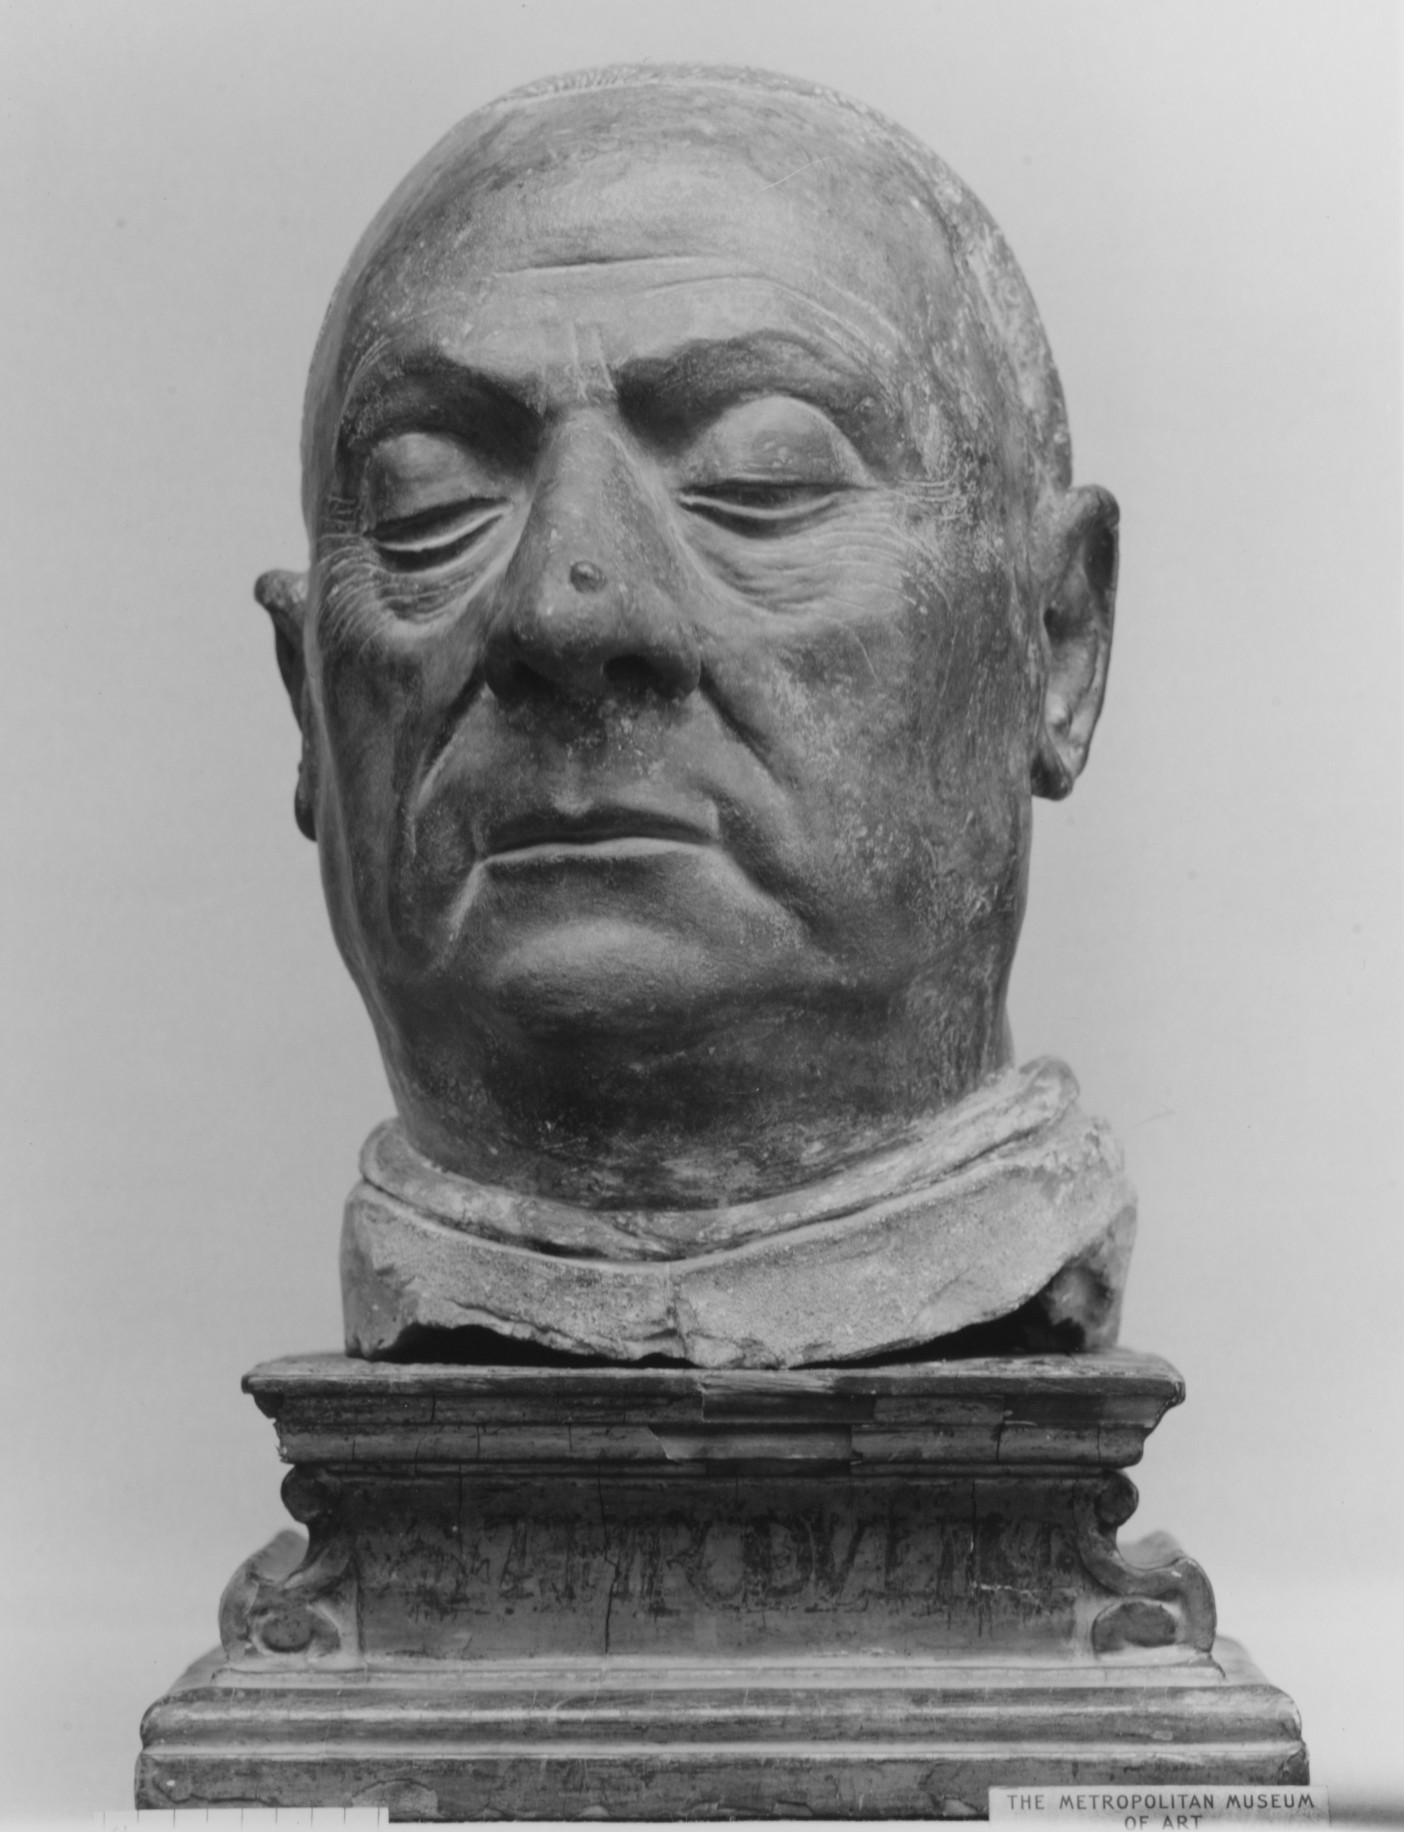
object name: head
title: A man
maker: guido mazzoni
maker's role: artist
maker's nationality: italian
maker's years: 1445-1518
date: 1501-1600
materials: terracotta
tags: heads,men